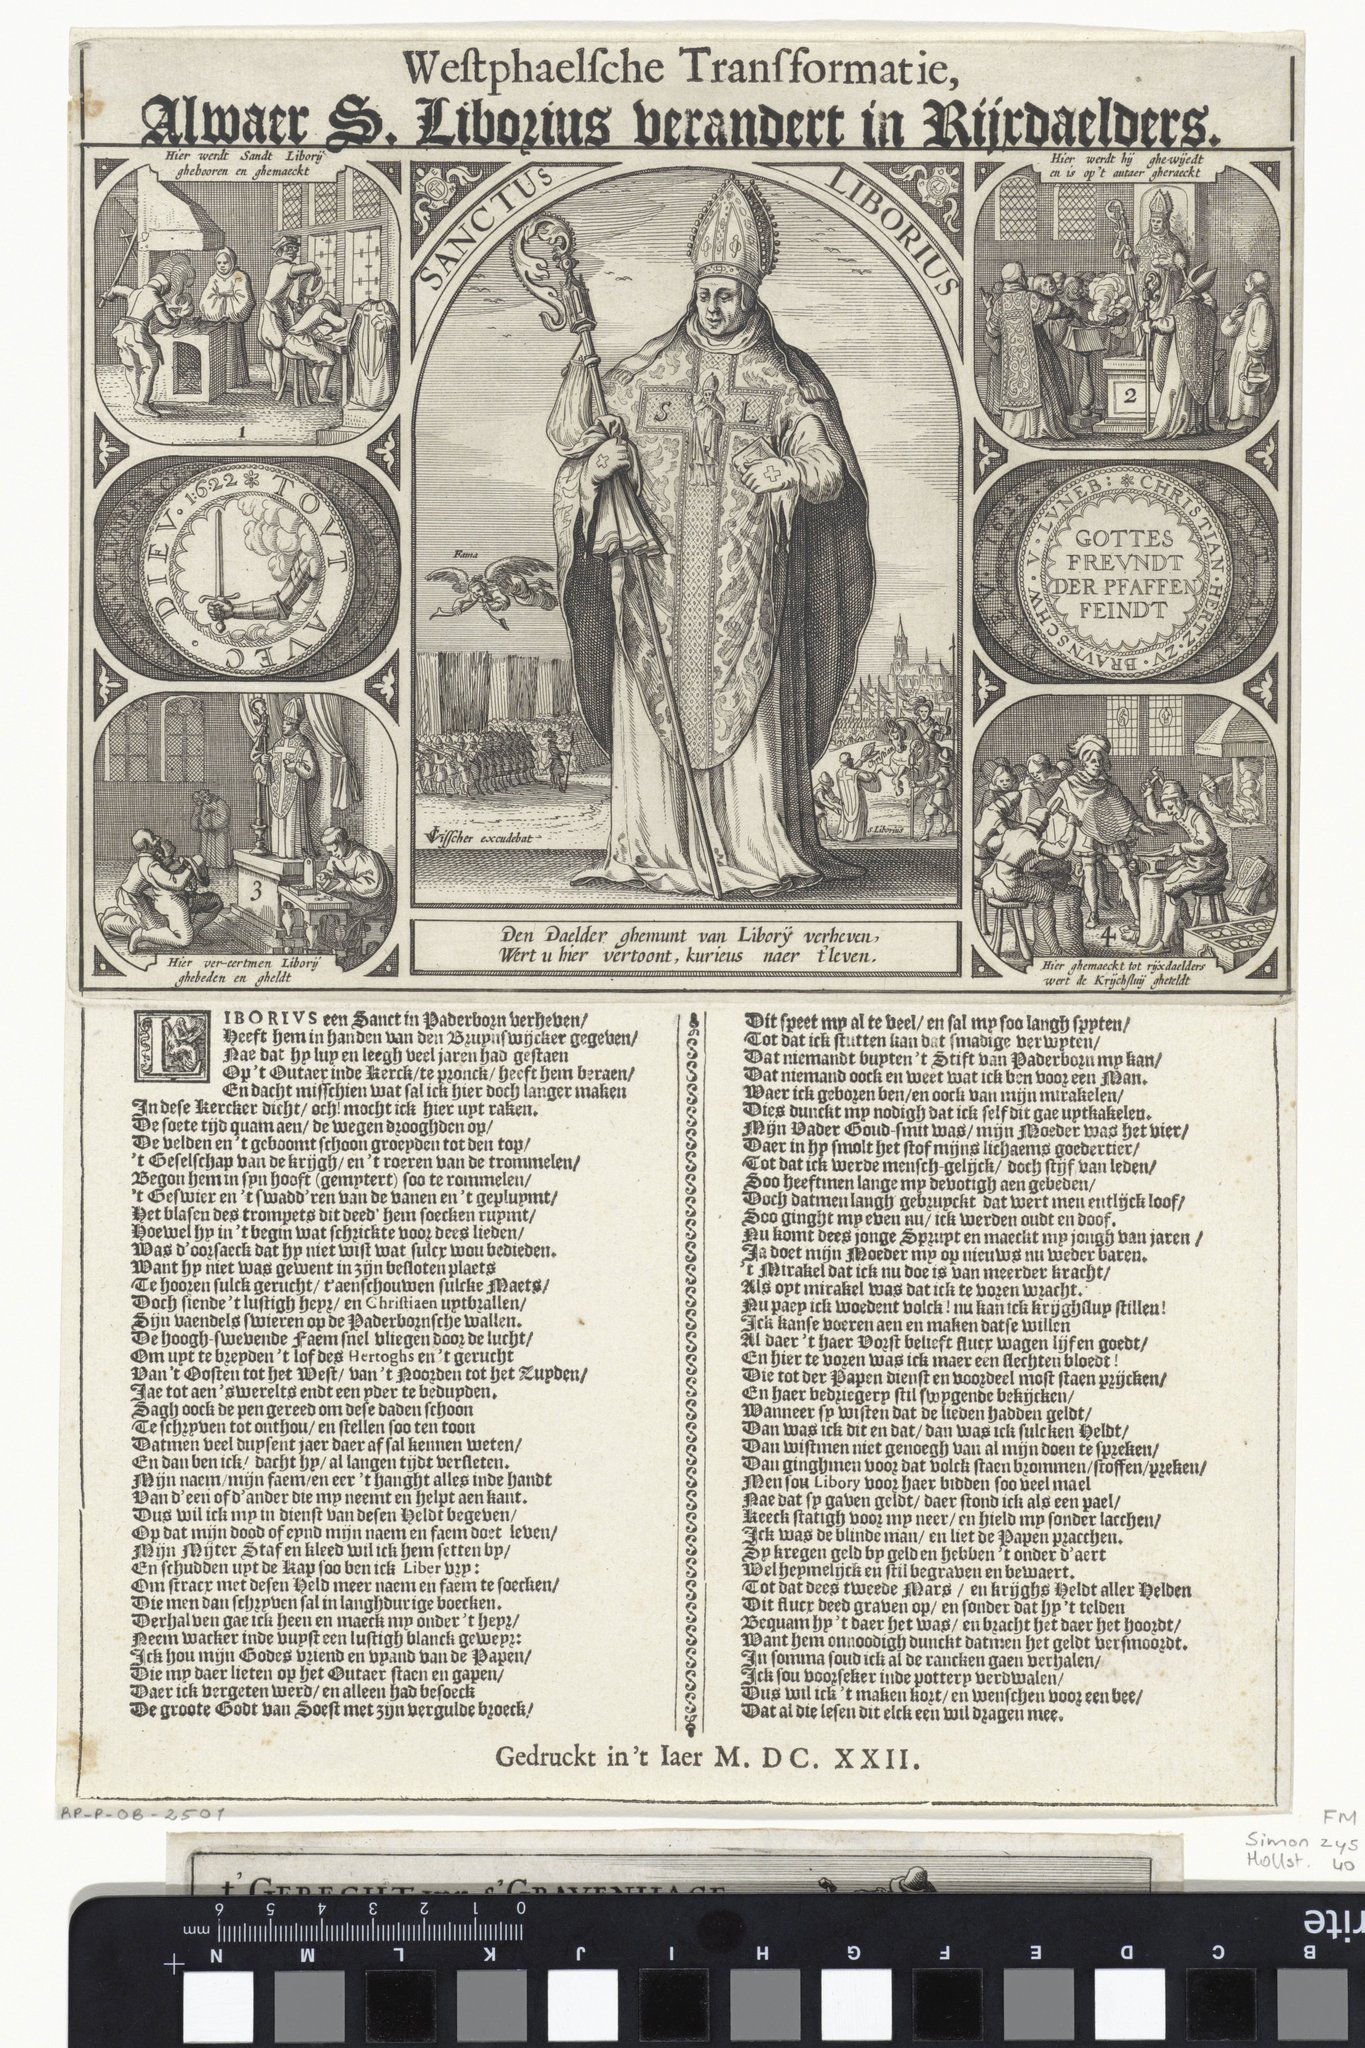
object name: print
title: Westphaelsche Transformatie, Alwaer S. Liborius verandert in Rijxdaelders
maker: claes jansz. visscher (ii)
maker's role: draughtsman, print maker, publisher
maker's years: 1586-1652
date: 1622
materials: paper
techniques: etching, letterpress printing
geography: amsterdam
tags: preparing of material by melting, male saints (with name)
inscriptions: collector's mark: Lugt 240, caption: ‘Den Daelder...naer 't leven.’, title: ‘Westphaelsche Transformatie, / Alwaer S. Liborius verandert in Rijxdaelders’, title: ‘SANCTUS LIBORIUS’, address: ‘CIVisscher excudebat’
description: Christiaan hertog van Brunswijk (ritmeester in Staatse dienst) laat het zilveren beeld van de heilige Liborius afkomstig uit een kerk te Munster omsmelten tot rijksdaalders om zijn soldaten te kunnen betalen, 1622. Centraal het beeld van de heilige, hieromheen in vier scènes de vervaardiging van het beeld, de wijding, het aanbidden en tenslotte het omsmelten tot geldstukken. Daartussen afbeeldingen van de voor- en achterzijde van een geldstuk. Onder de plaat een tekst in twee kolommen in het Nederlands.